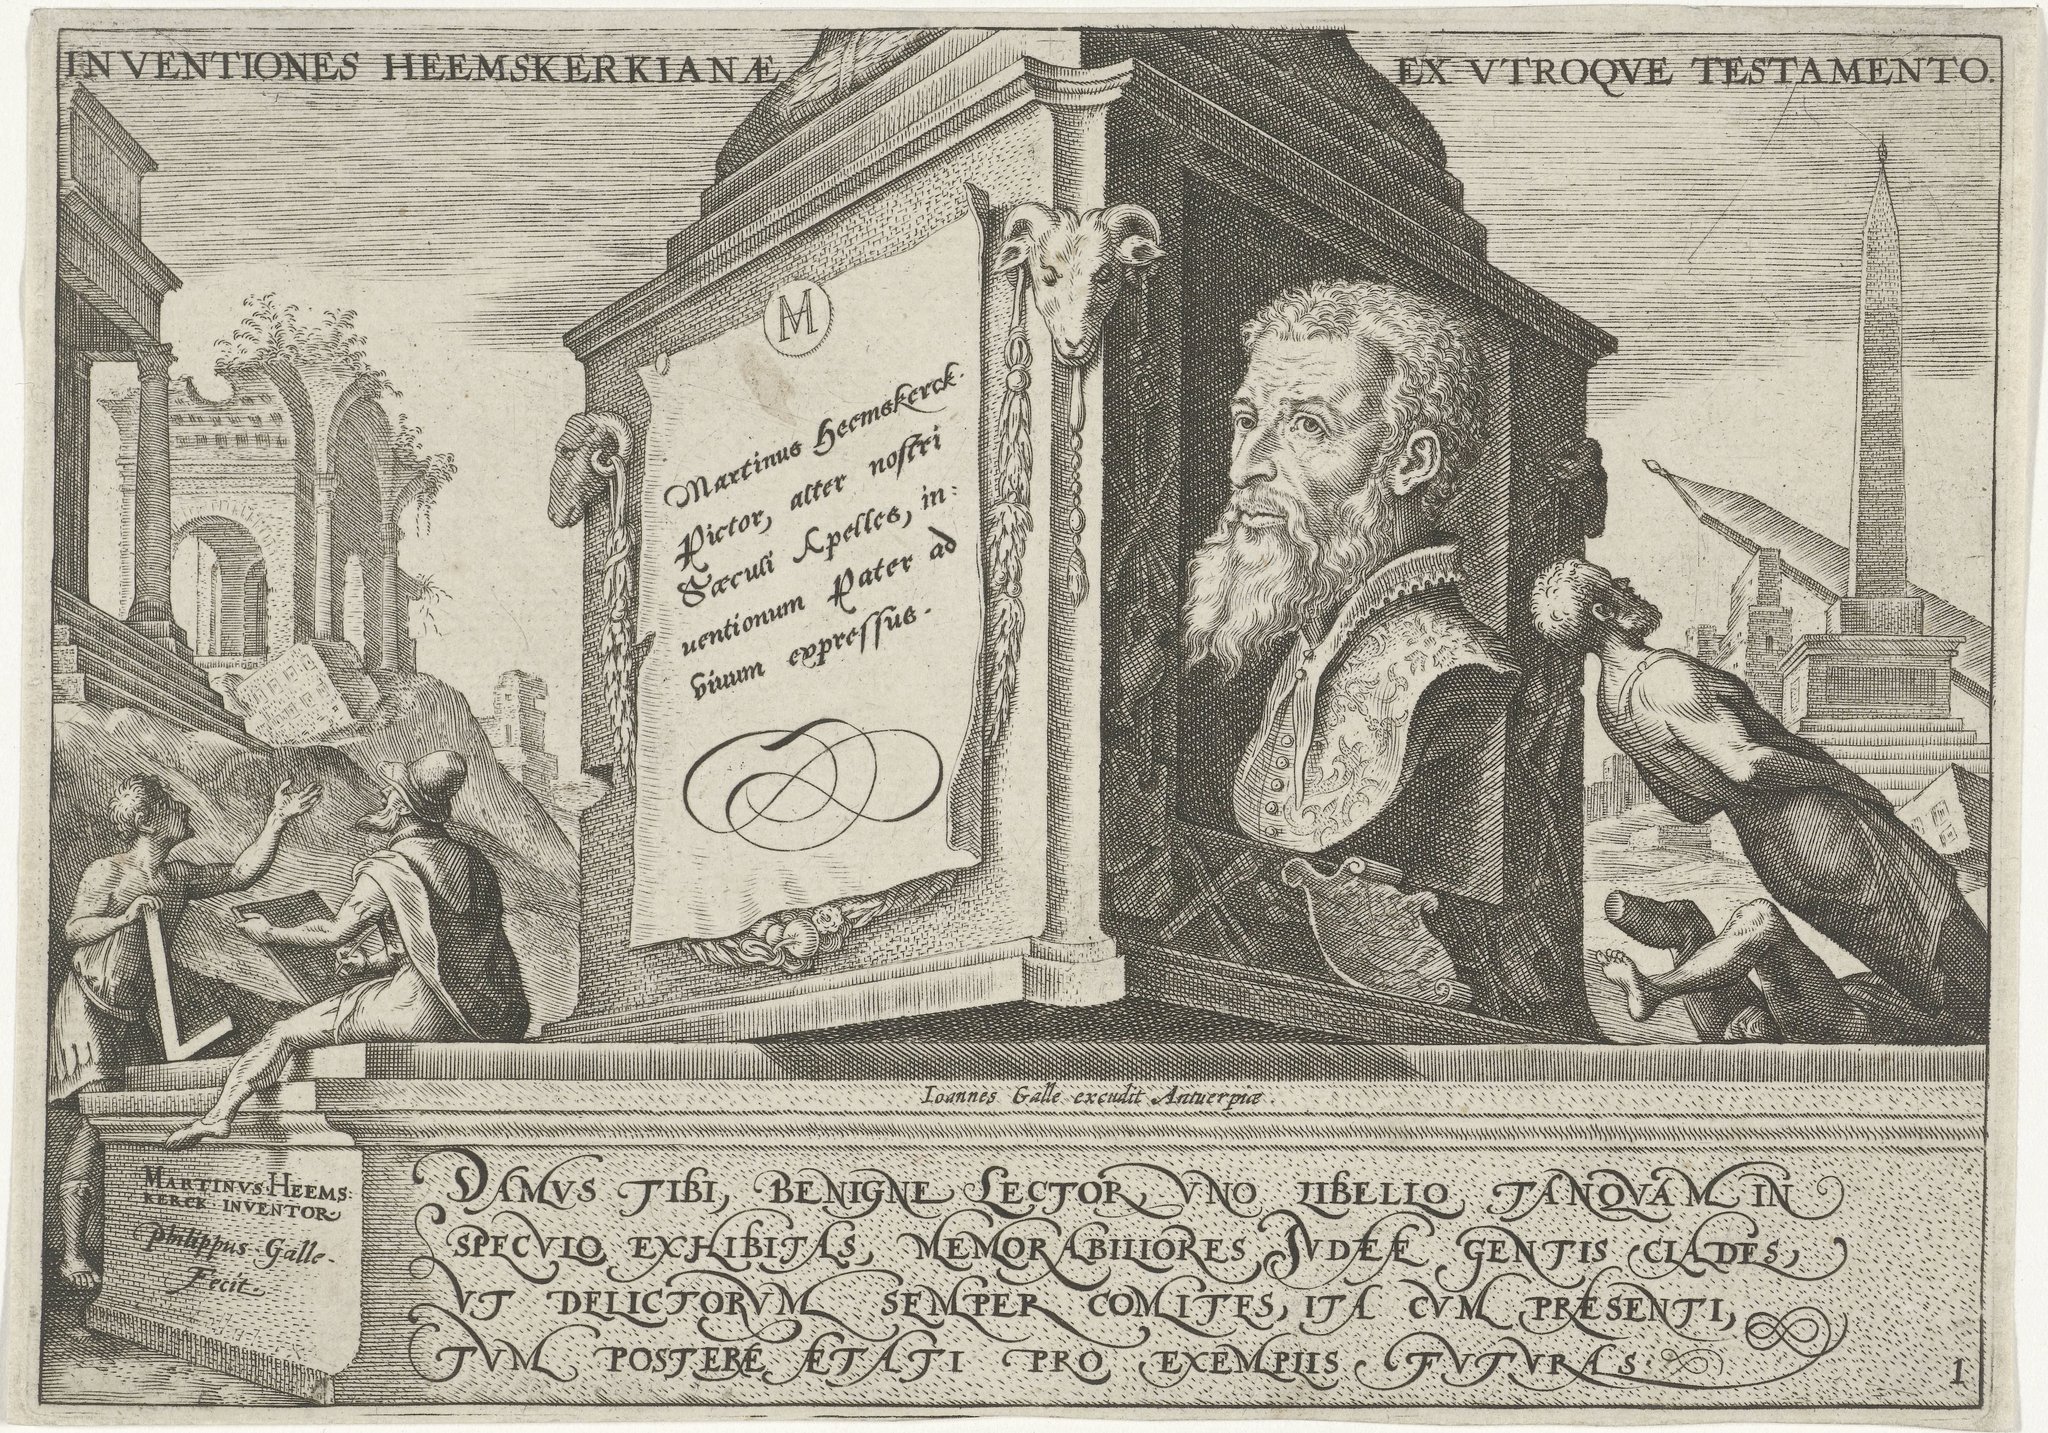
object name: titelprent, frontispice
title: De onheilsdagen van het Joodse volk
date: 1569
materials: paper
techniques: engraving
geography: haarlem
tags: haarlem, painter, print maker, draughtsman, maarten van heemskerck, bible, portrait, self-portrait of painter, tools, implements of architect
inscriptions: signature: ‘MARTINUS HEEMS:/ KERCK. INVENTOR / Philippus Galle / Fecit’, caption: ‘DAMUS TIBI, BENIGNE LECTOR, UNE LIBELLO TANQUAM IN / SPECULO EXHIBITAS, MEMORABIBIORES JUDAEAE GENTIS CLADES, / UT DELICTORUM SEMPER COMITES, ITA CUM PRAESENTI, / TUM POSTERAE AETATI PRO EXEMPLIS FUTURAS.’, signature: ‘MH / Martinus Heemskerck. / Pictor....expressus’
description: Titelprent van een serie van 21 genummerde prenten met de onheilsdagen in de geschiedenis van het Joodse volk als morele voorbeelden. Het portret van Maarten van Heemskerck is weergegeven op de sokkel van een zuil, omgeven door attributen van de architectuur en schilderkunst. Links zitten twee architecten, rechts enkele liggende antieke beelden. Op de achtergrond ruïnes van antieke gebouwen en twee obelisken.